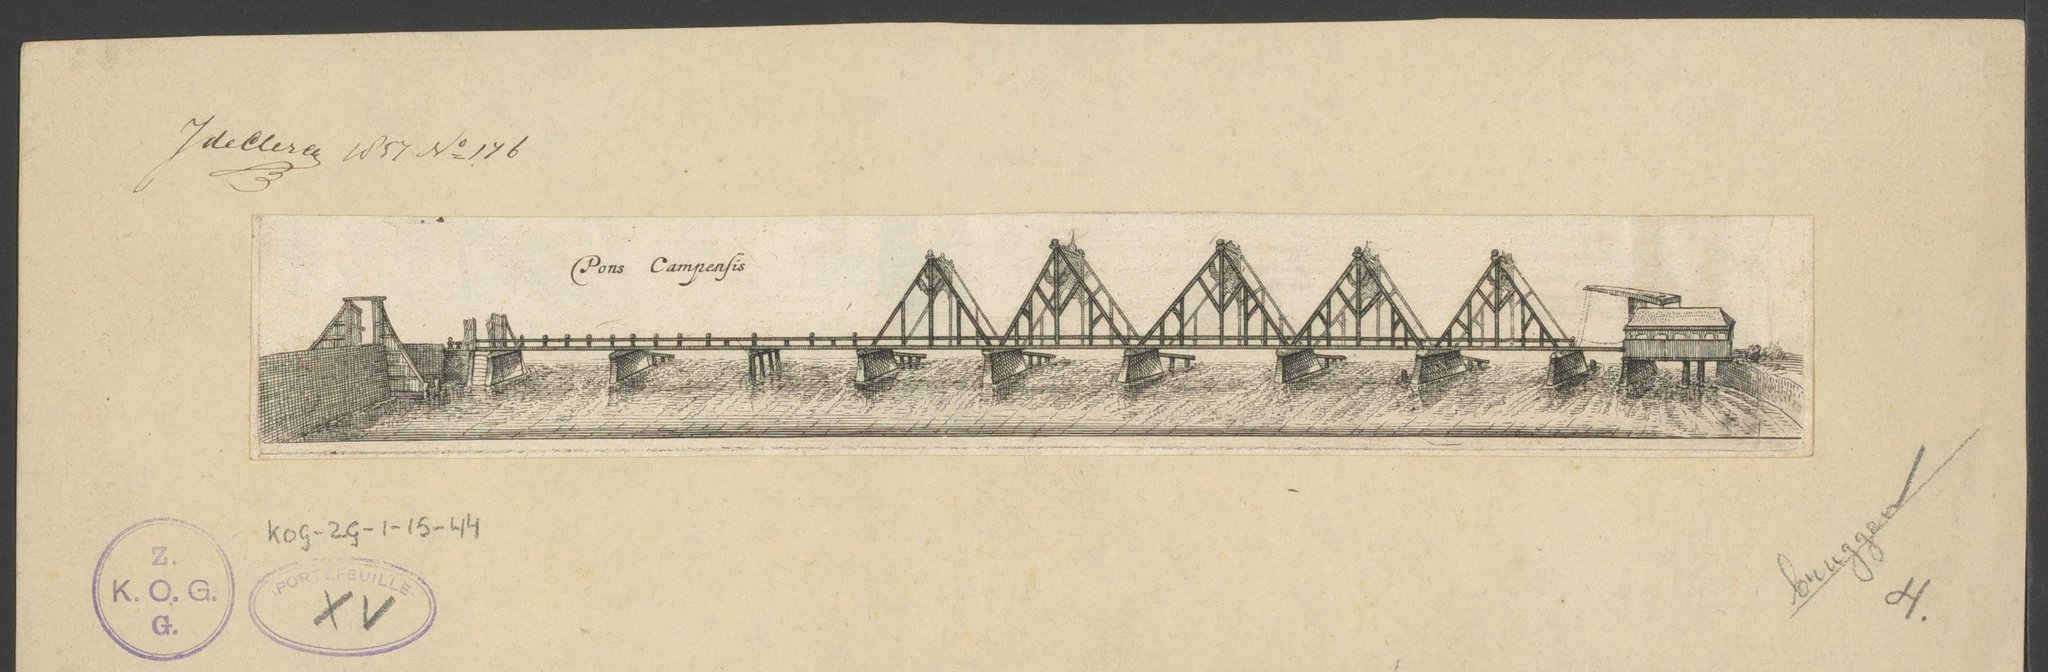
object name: print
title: Pons Camensis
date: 1648-1649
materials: paper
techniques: engraving, etching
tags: bridge, bridge in city across river, canal, etc.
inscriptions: stamp, collector's mark: Lugt 1641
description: Brug over de IJssel voor Kampen. Op het verso de legenda en vesting van de plattegrond van Kampen. Onderwerpsrubrieken binnen de Atlas Zeden en Gewoonten: Handel, nijverheid en verkeer, Bruggen.